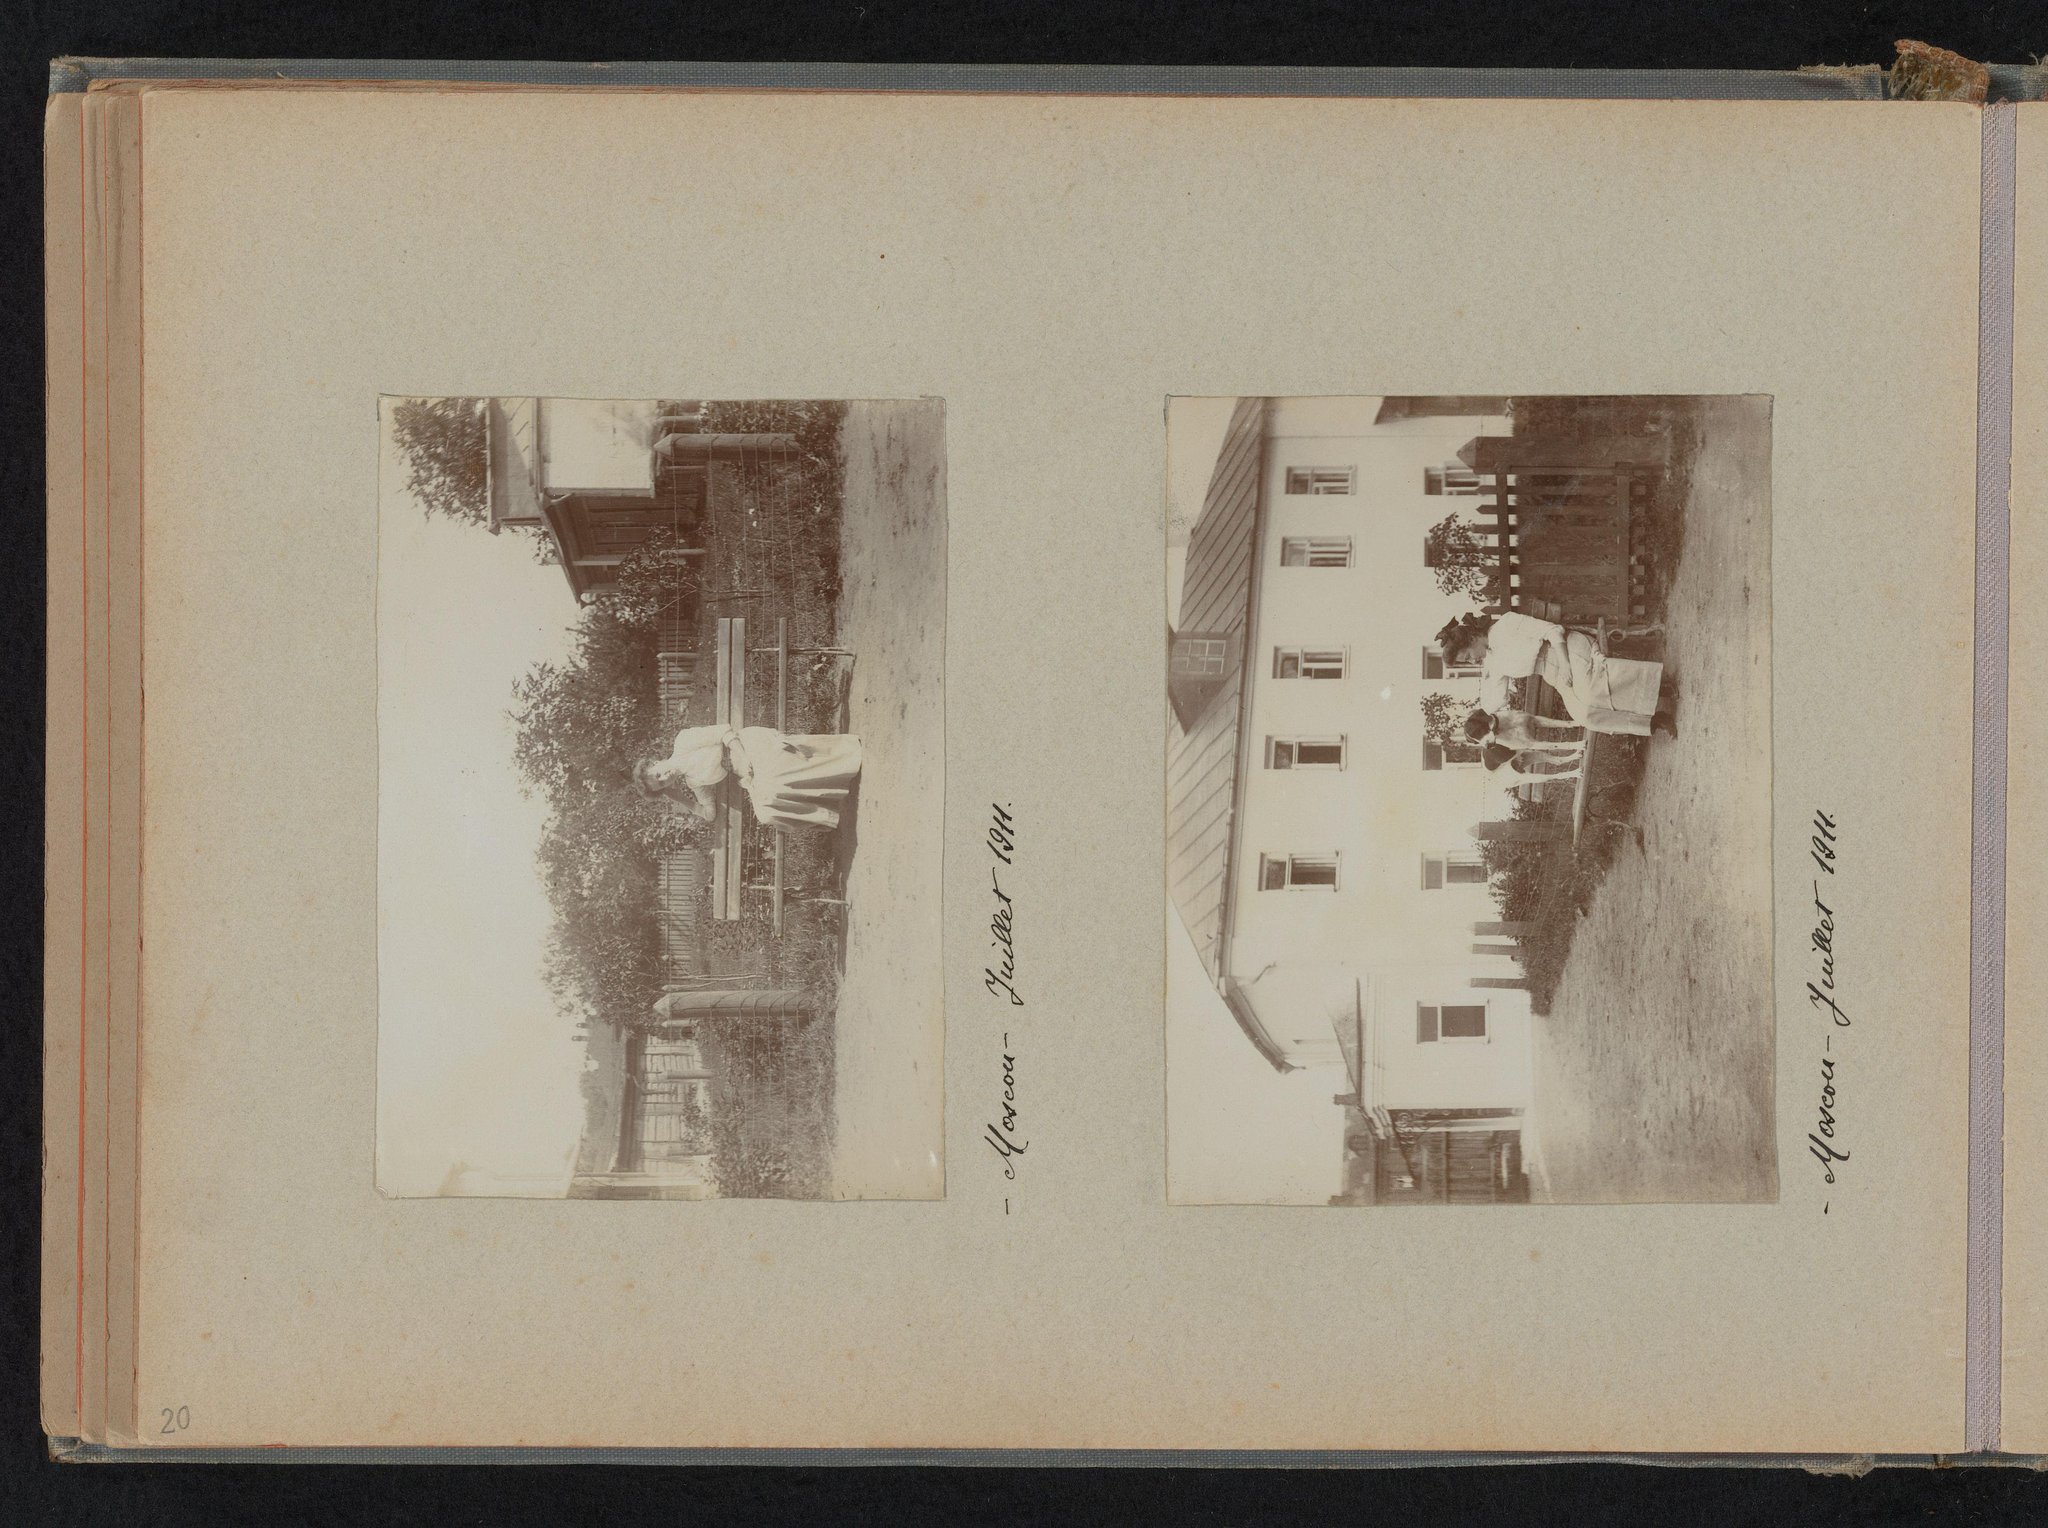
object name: album leaf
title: Vrouw op een bank voor een tuin met en vrouw met hond op een bank voor een huis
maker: Anonymous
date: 1907-1911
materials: paper, cardboard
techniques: collodion silver print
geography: moscow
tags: bench, historical persons - bb - woman, dog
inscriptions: inscription: ‘- Moscou - Juillet 1911.’, inscription: ‘- Moscou - Juillet 1911.’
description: Deze foto's maken deel uit van een album.